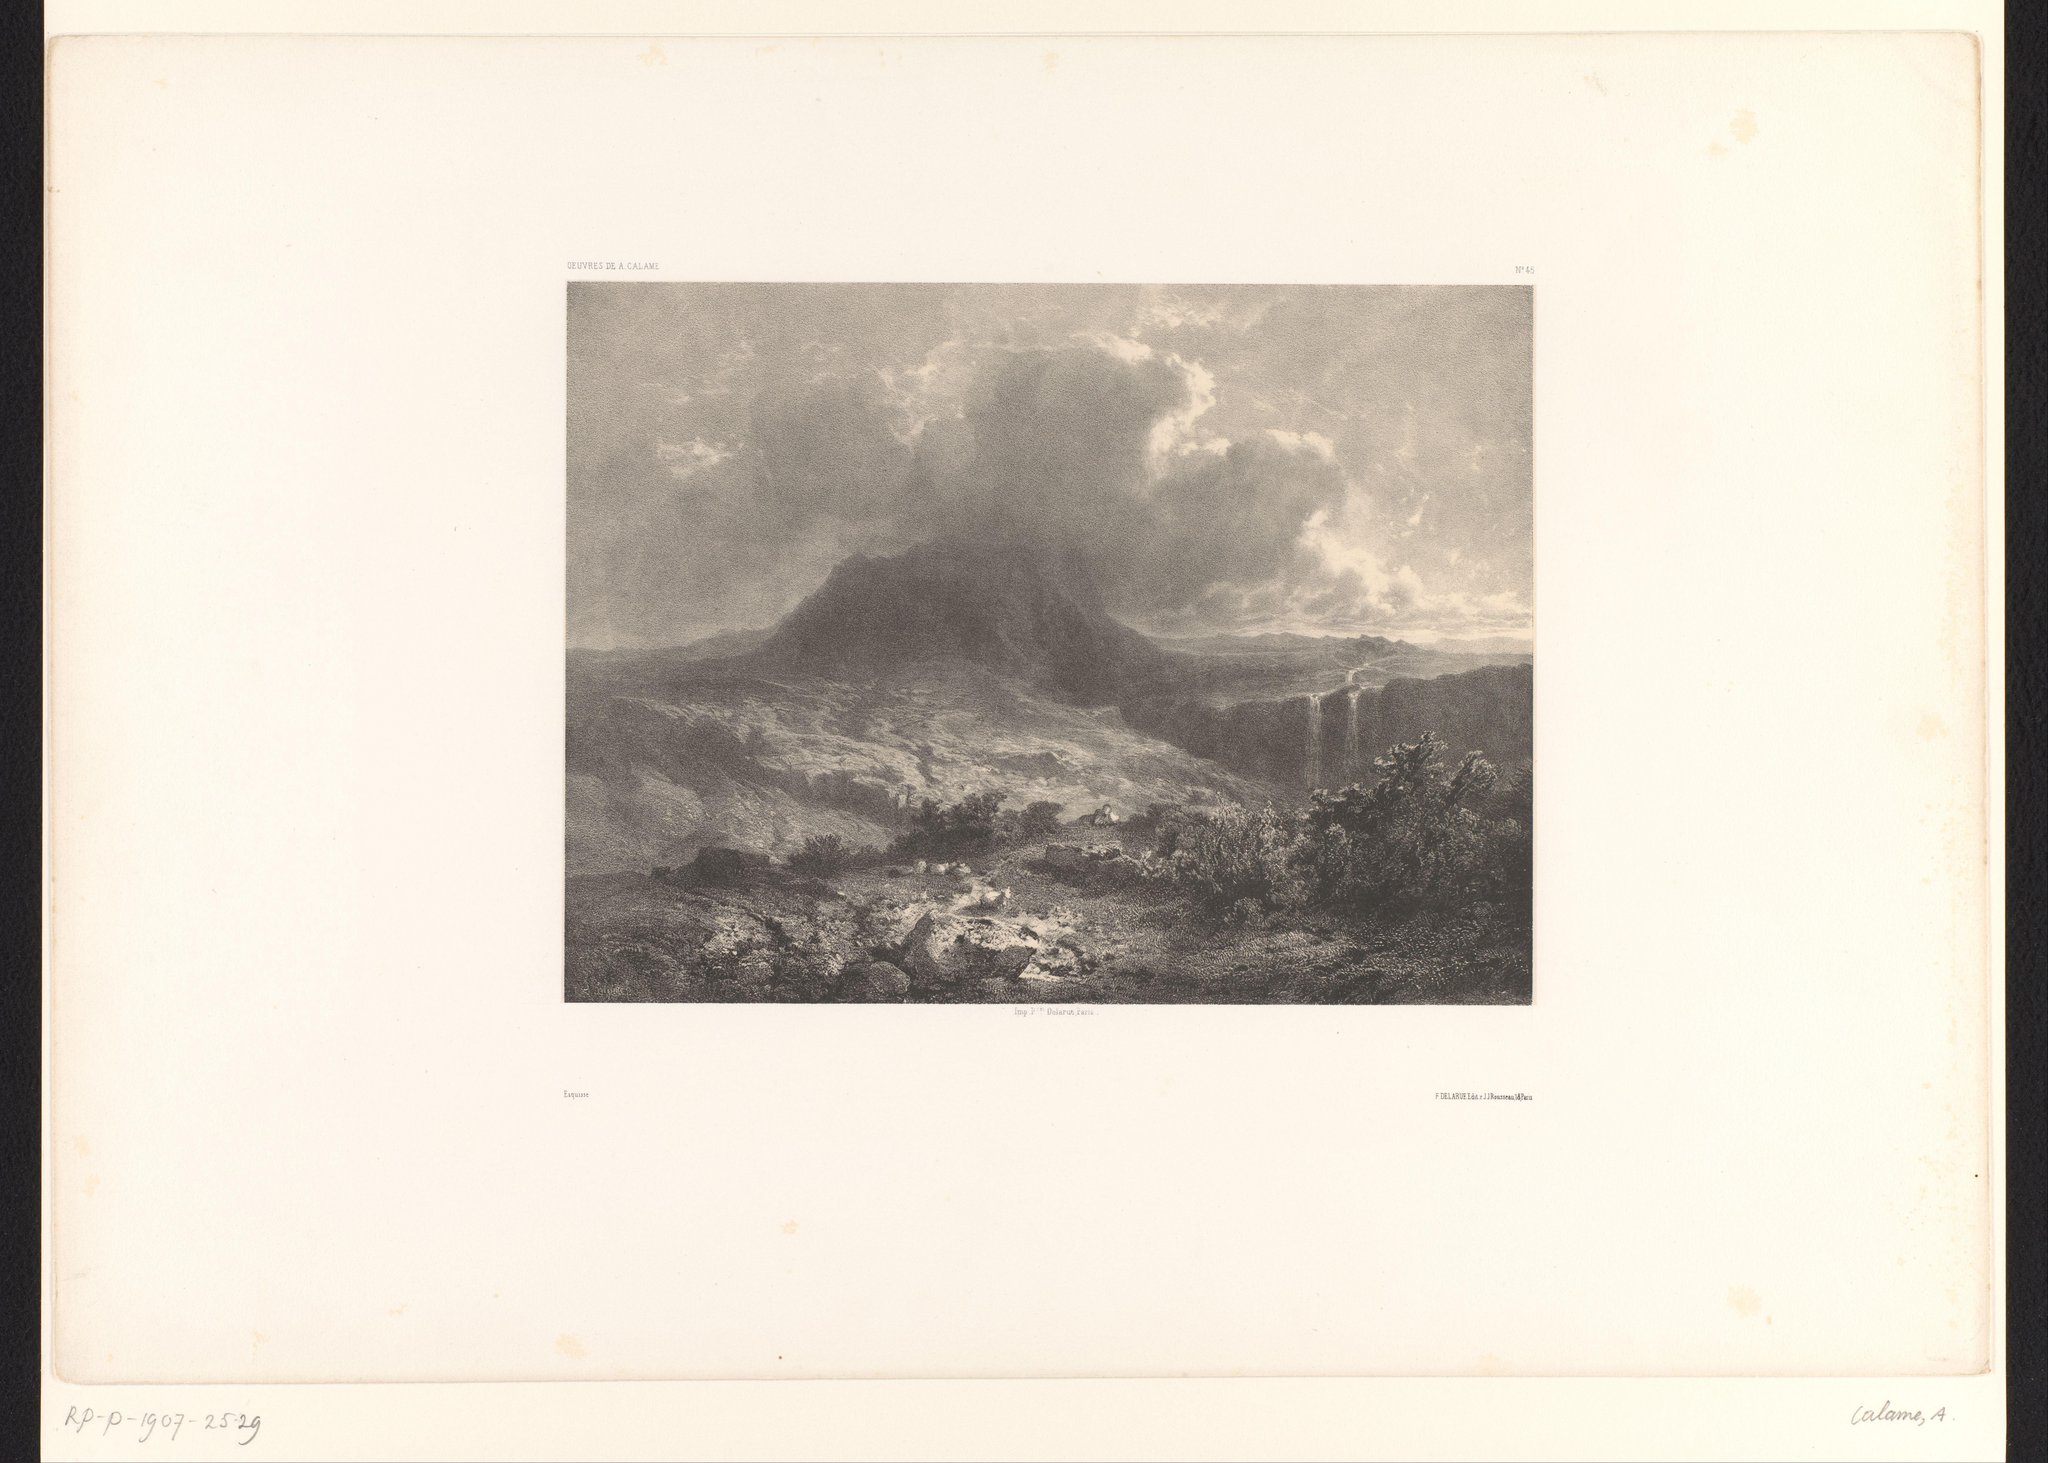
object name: print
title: Oeuvres de A. Calame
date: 1852-1855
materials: paper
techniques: lithograph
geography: paris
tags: waterfall, ravine, chasm, abyss, canyon, sunlight, mountains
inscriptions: collector's mark: Lugt 2228a